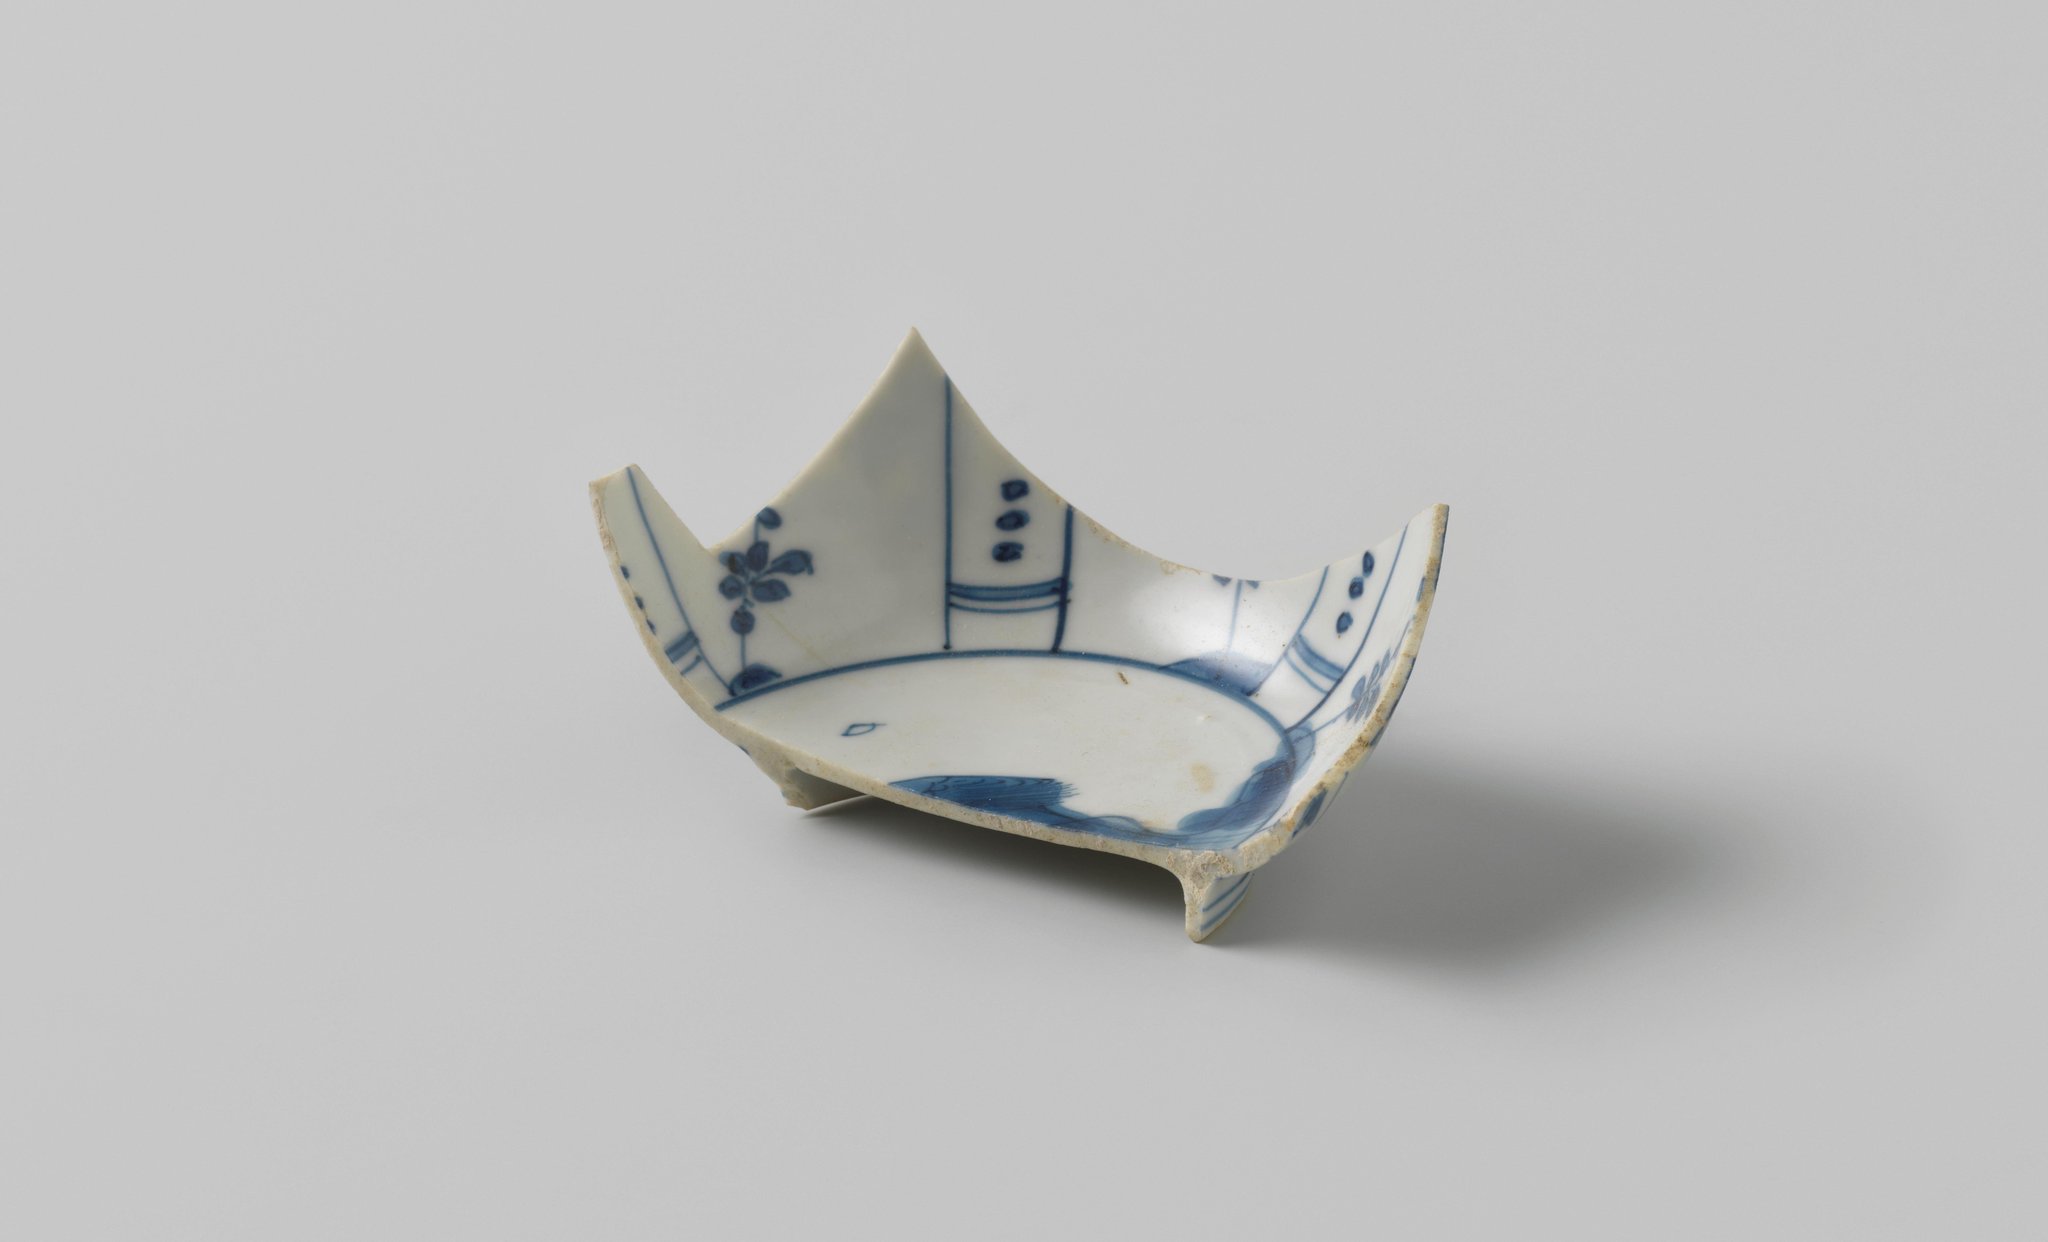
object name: kraaikop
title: Fragment kraaikop uit V.O.C.-schip de 'Witte Leeuw'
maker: Anonymous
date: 1613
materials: bone china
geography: jingdezhen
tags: verenigde oostindische compagnie, sint-helena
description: Fragment kraaikop uit V.O.C.-schip de 'Witte Leeuw'.